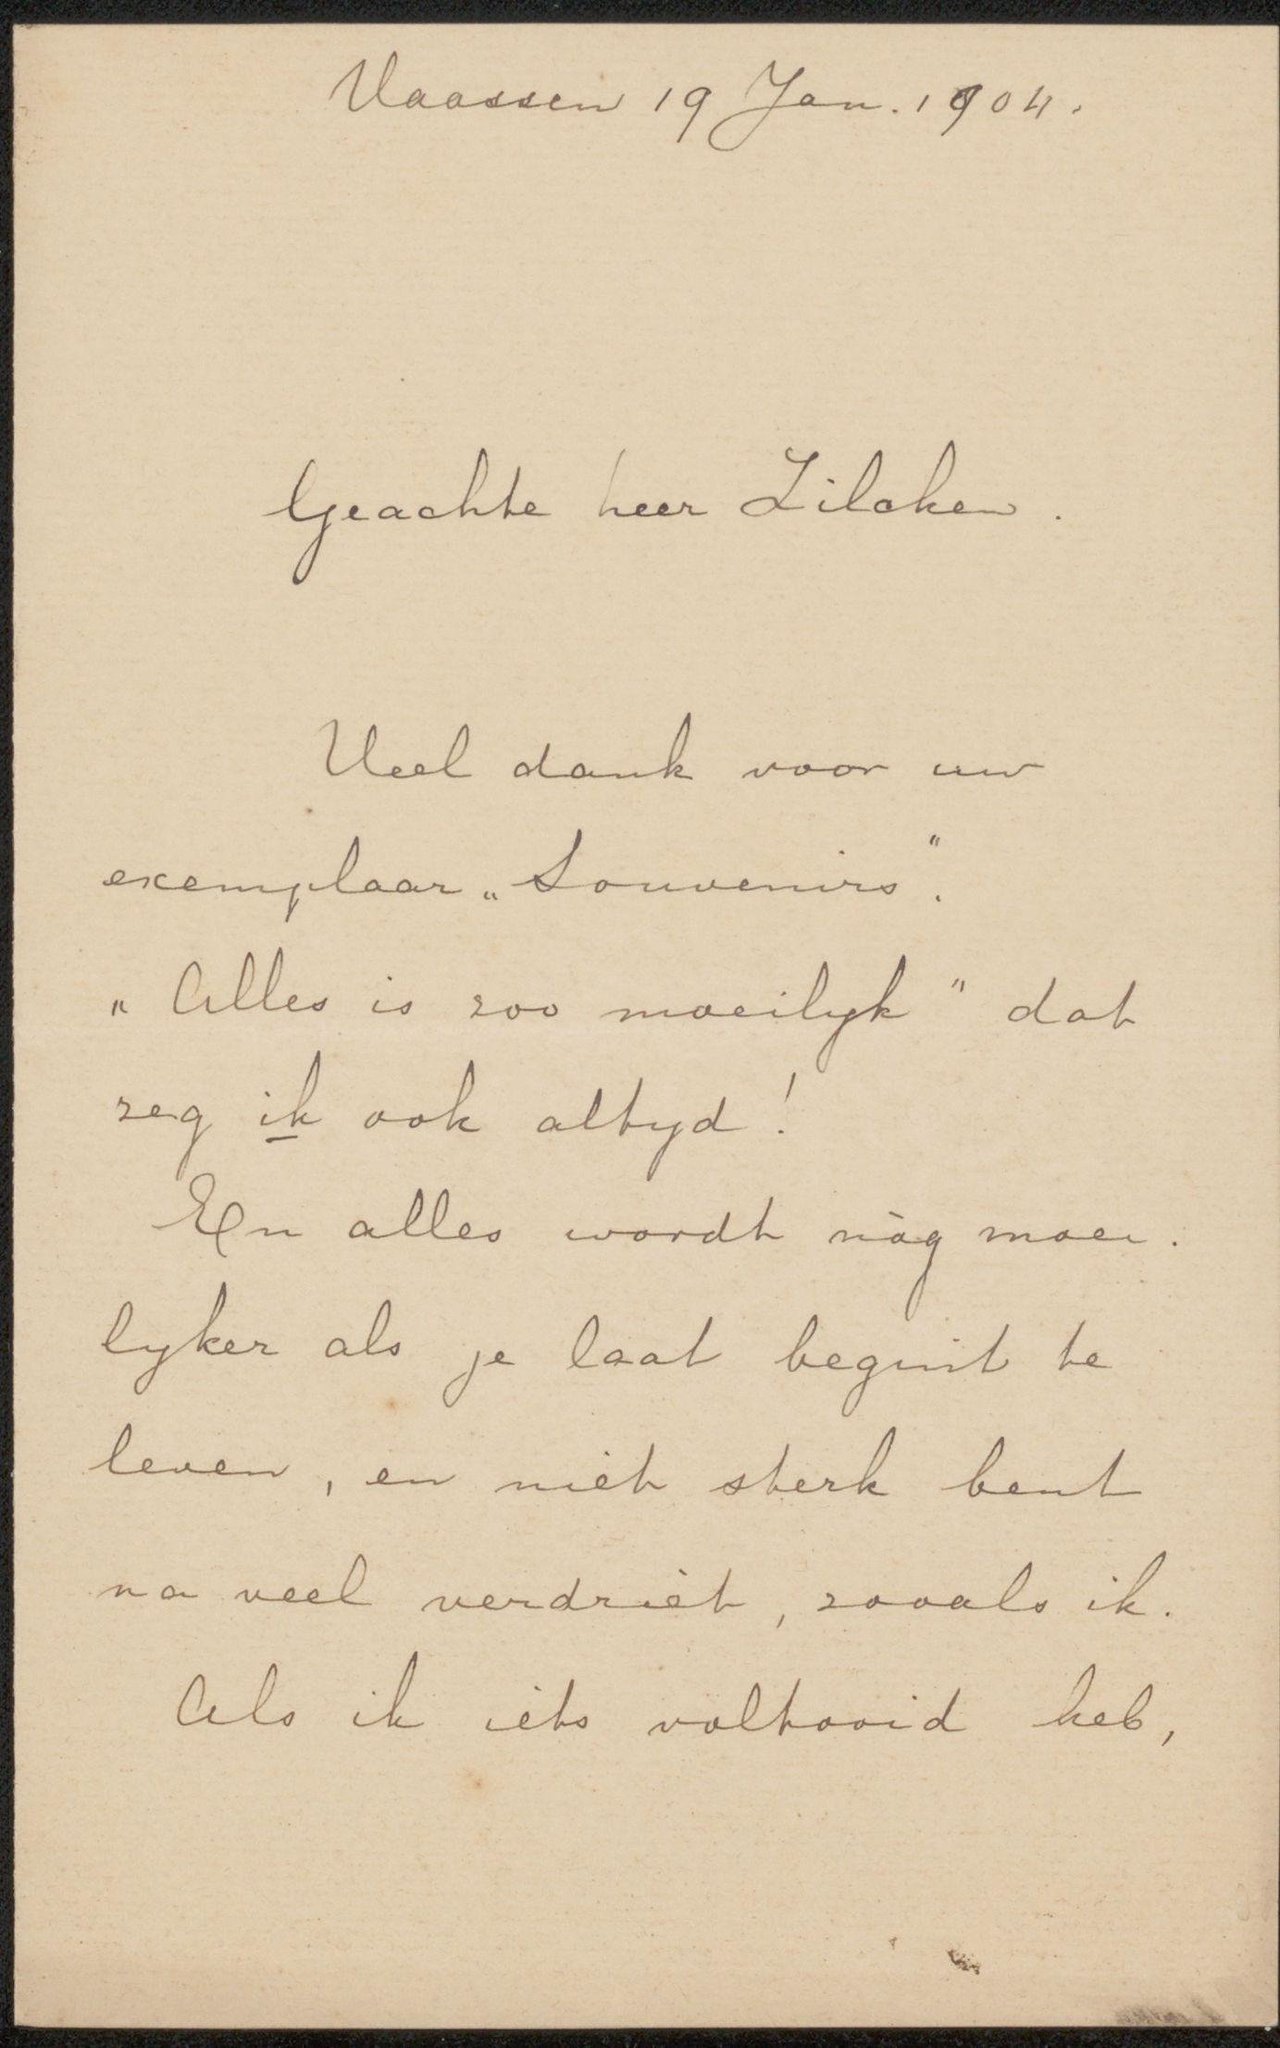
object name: letter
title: Brief aan Philip Zilcken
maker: marie metz-koning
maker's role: dichter, prozaschrijver, toneelschrijver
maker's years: 1864-1926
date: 1904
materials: ink, paper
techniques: pen, writing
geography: vaassen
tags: the hague, draughtsman, philip zilcken, passions, emotions, affections, diseases, printed matter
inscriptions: collector's mark: ‘RPK’, watermark